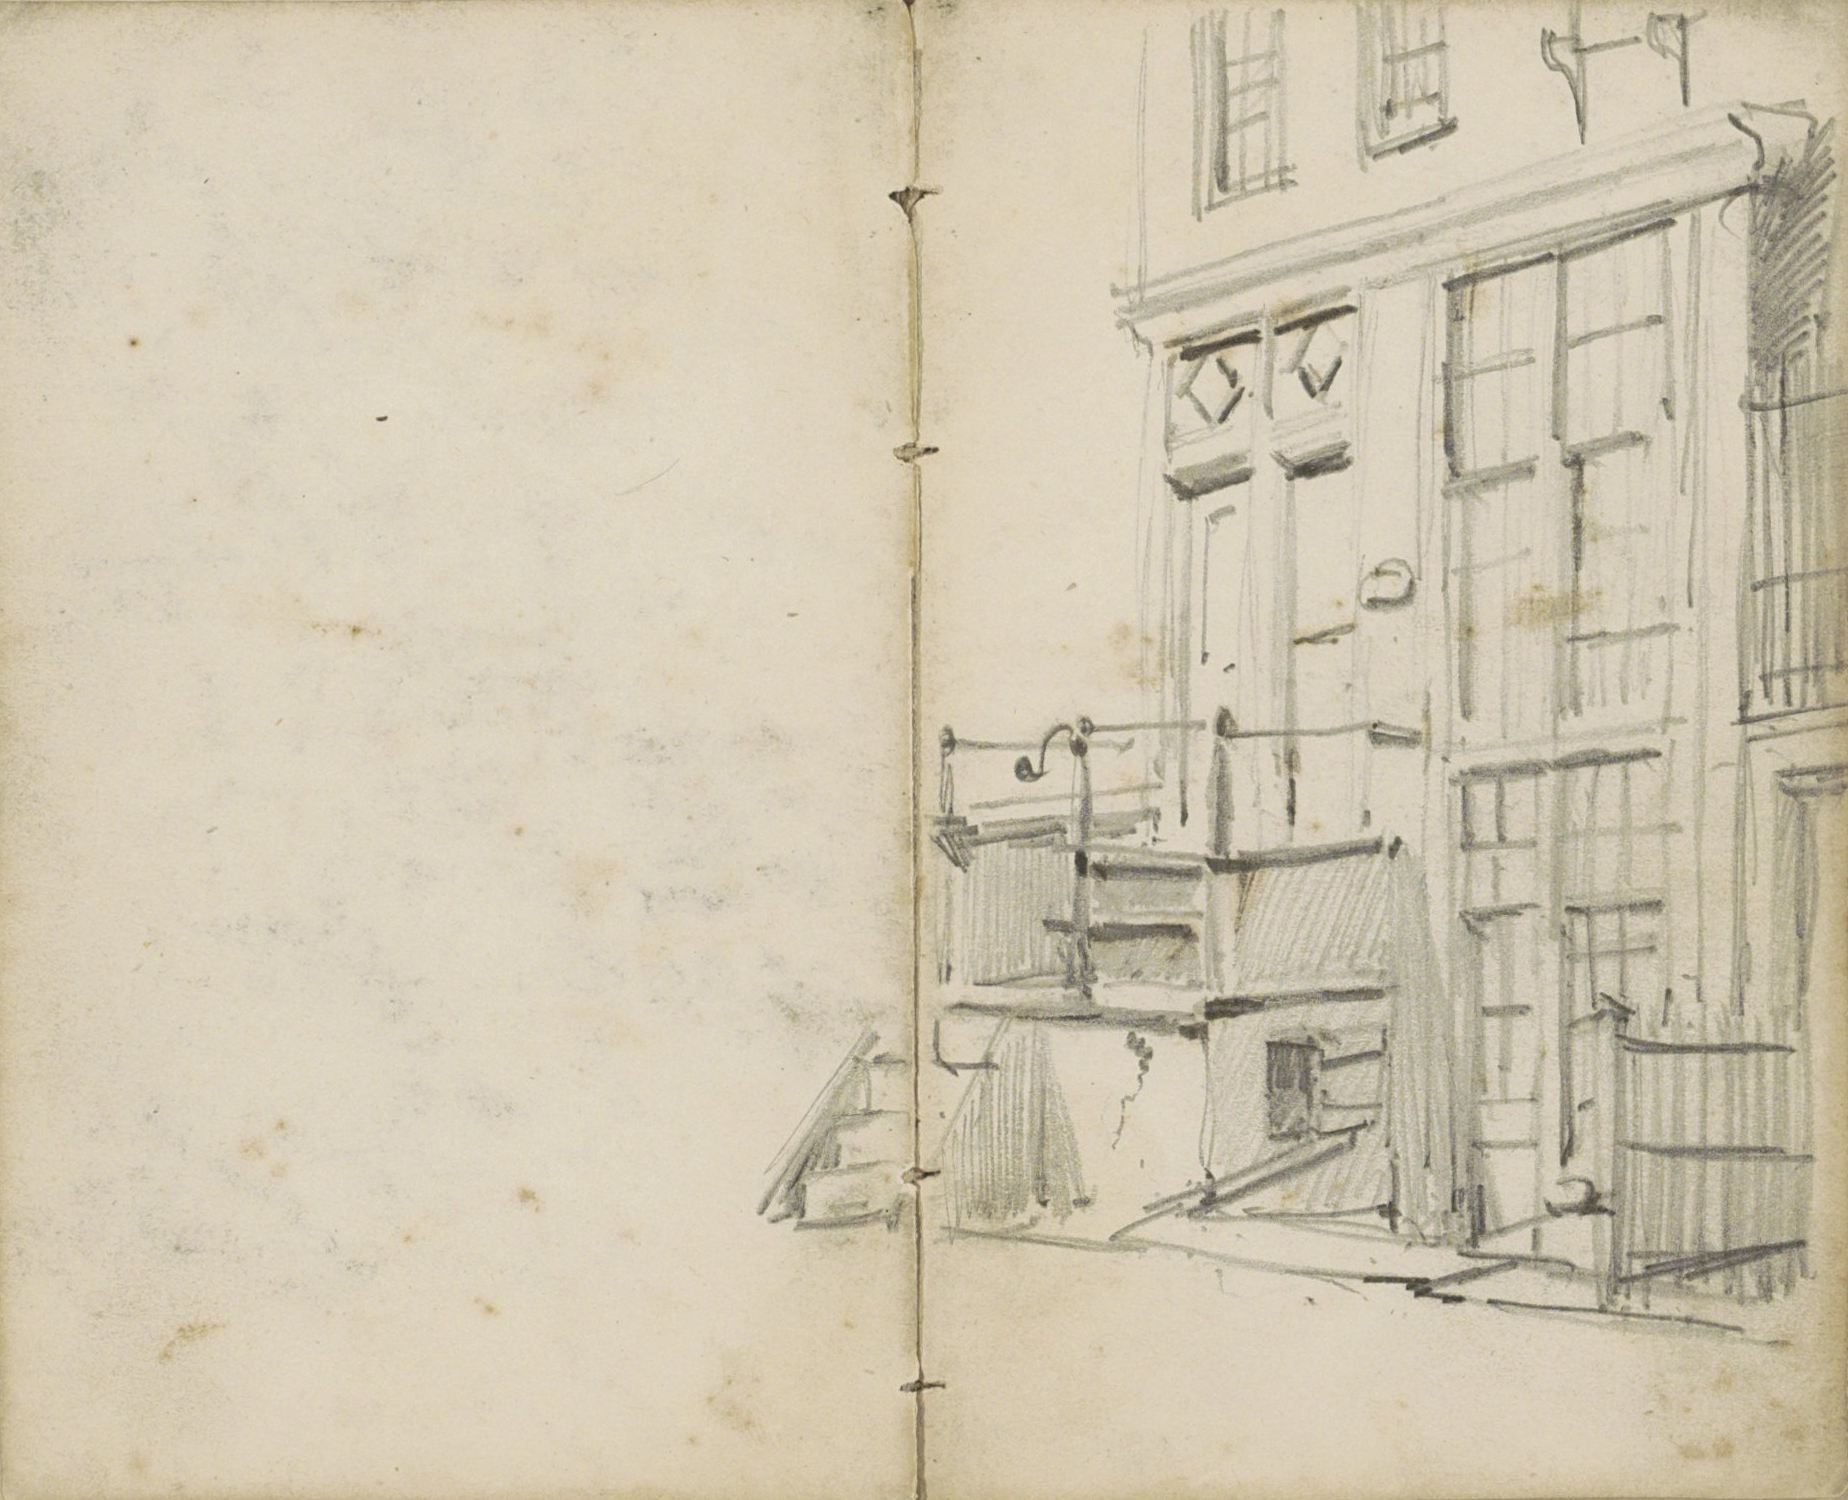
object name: sketchbook leaf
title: Hoekpand met een trap voor de ingang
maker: willem koekkoek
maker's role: draughtsman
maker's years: 1839-1895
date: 1849-1895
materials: paper, pencil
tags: flight of steps, façade (of house or building)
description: Blad 7 verso en 8 recto uit een schetsboek met 57 bladen.